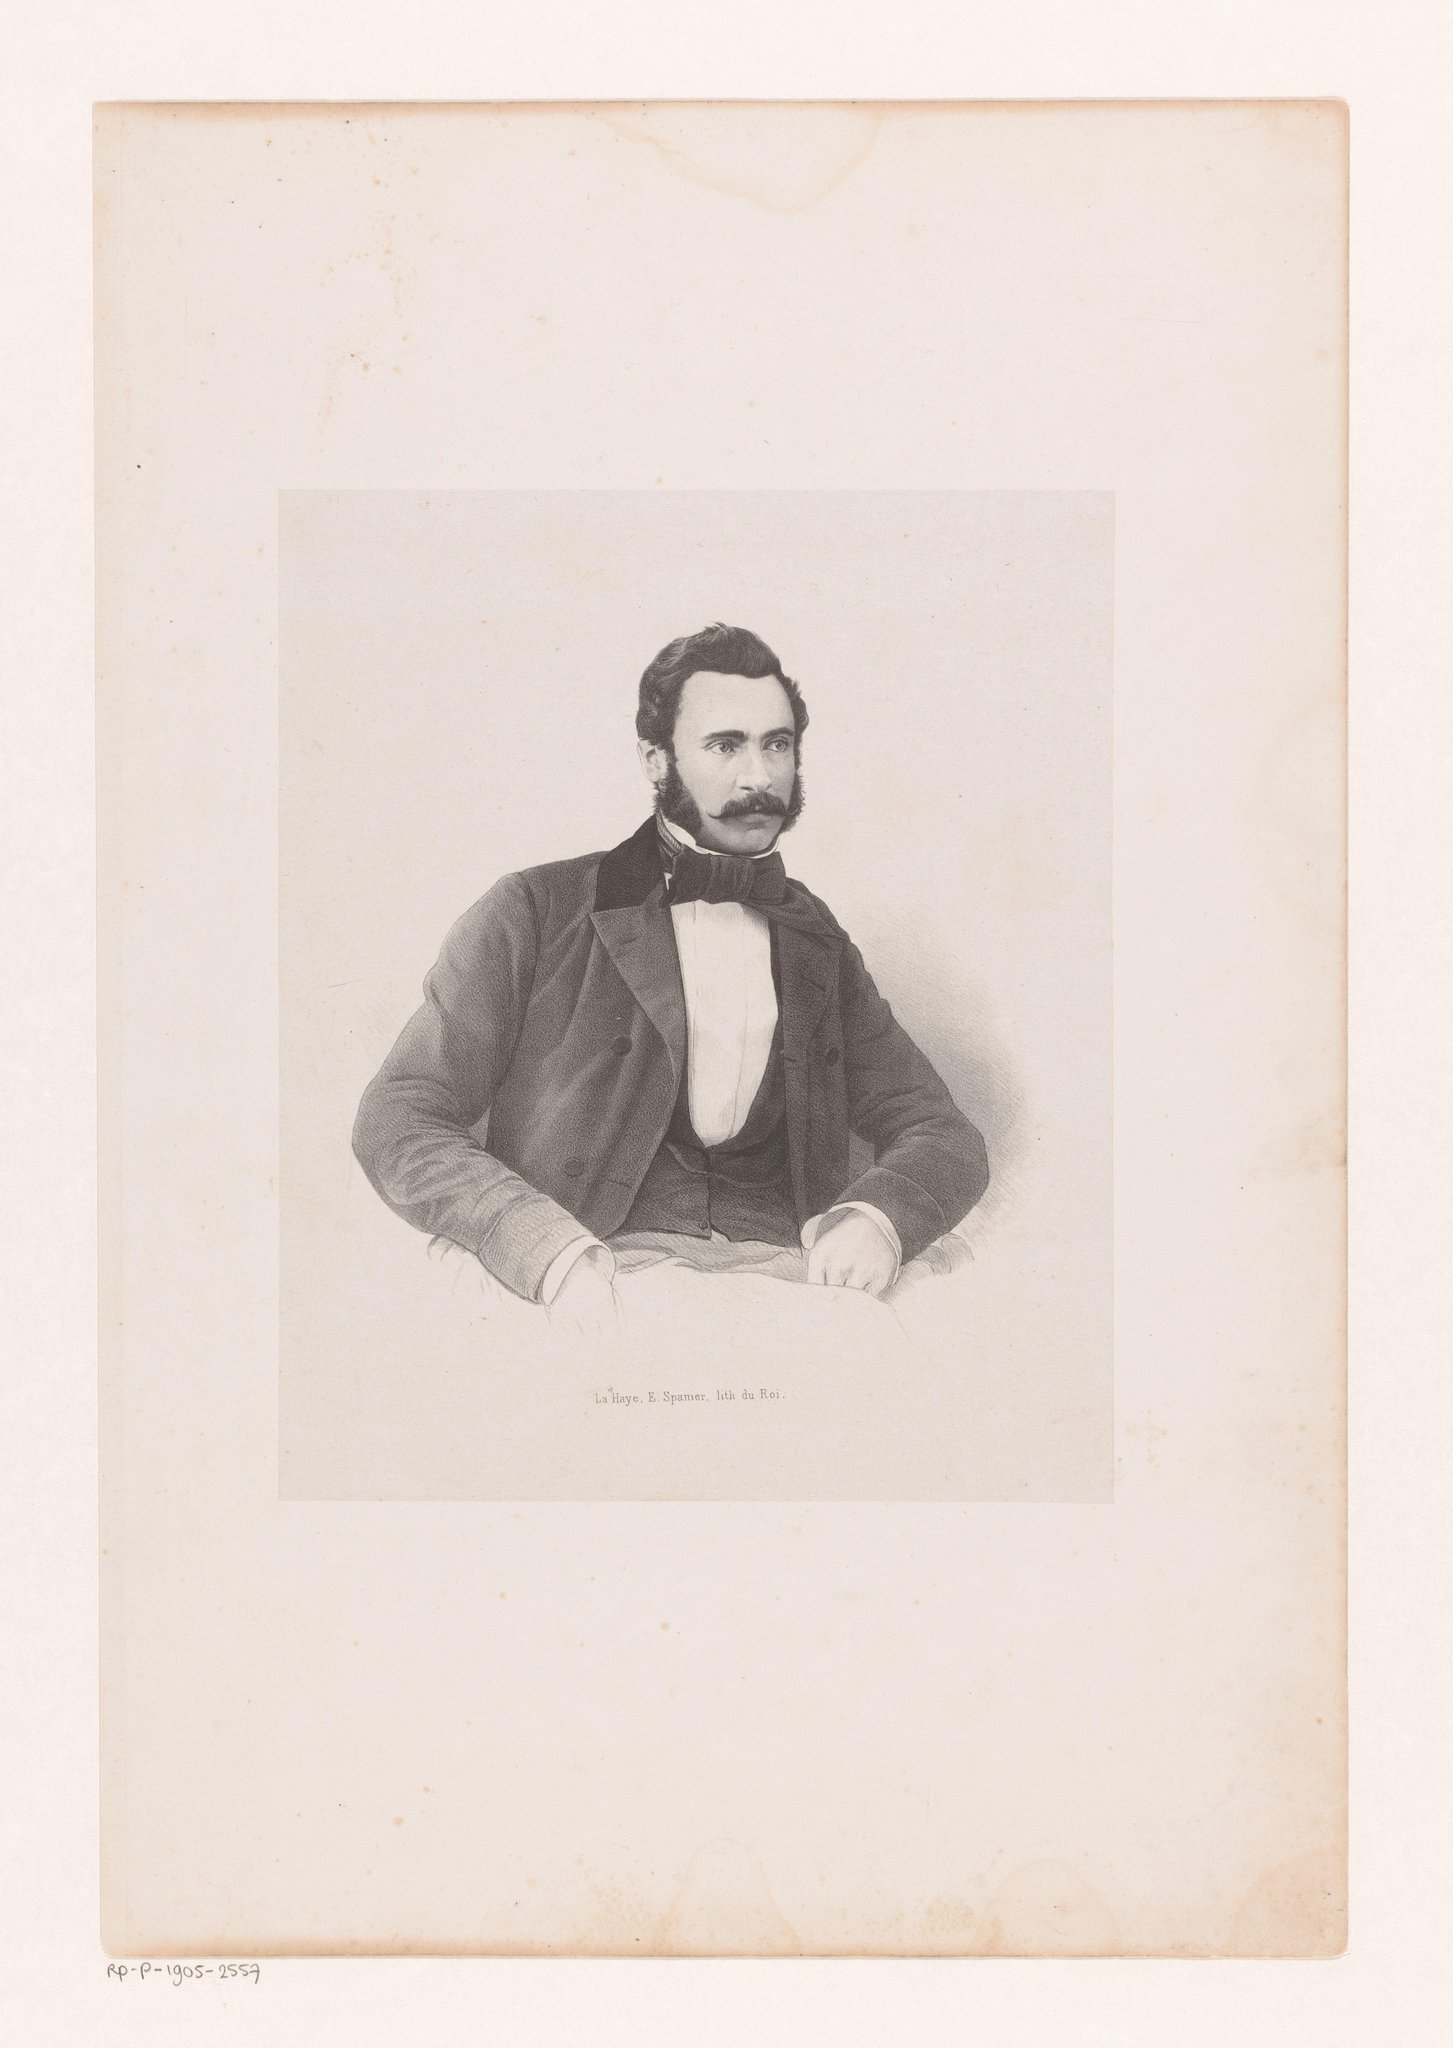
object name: print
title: Portret van een onbekende man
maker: johan hendrik hoffmeister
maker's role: print maker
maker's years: 1823-1904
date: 1851-1883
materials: paper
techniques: lithograph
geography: netherlands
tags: historical persons (+ (full) bust portrait)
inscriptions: collector's mark: Lugt 2228